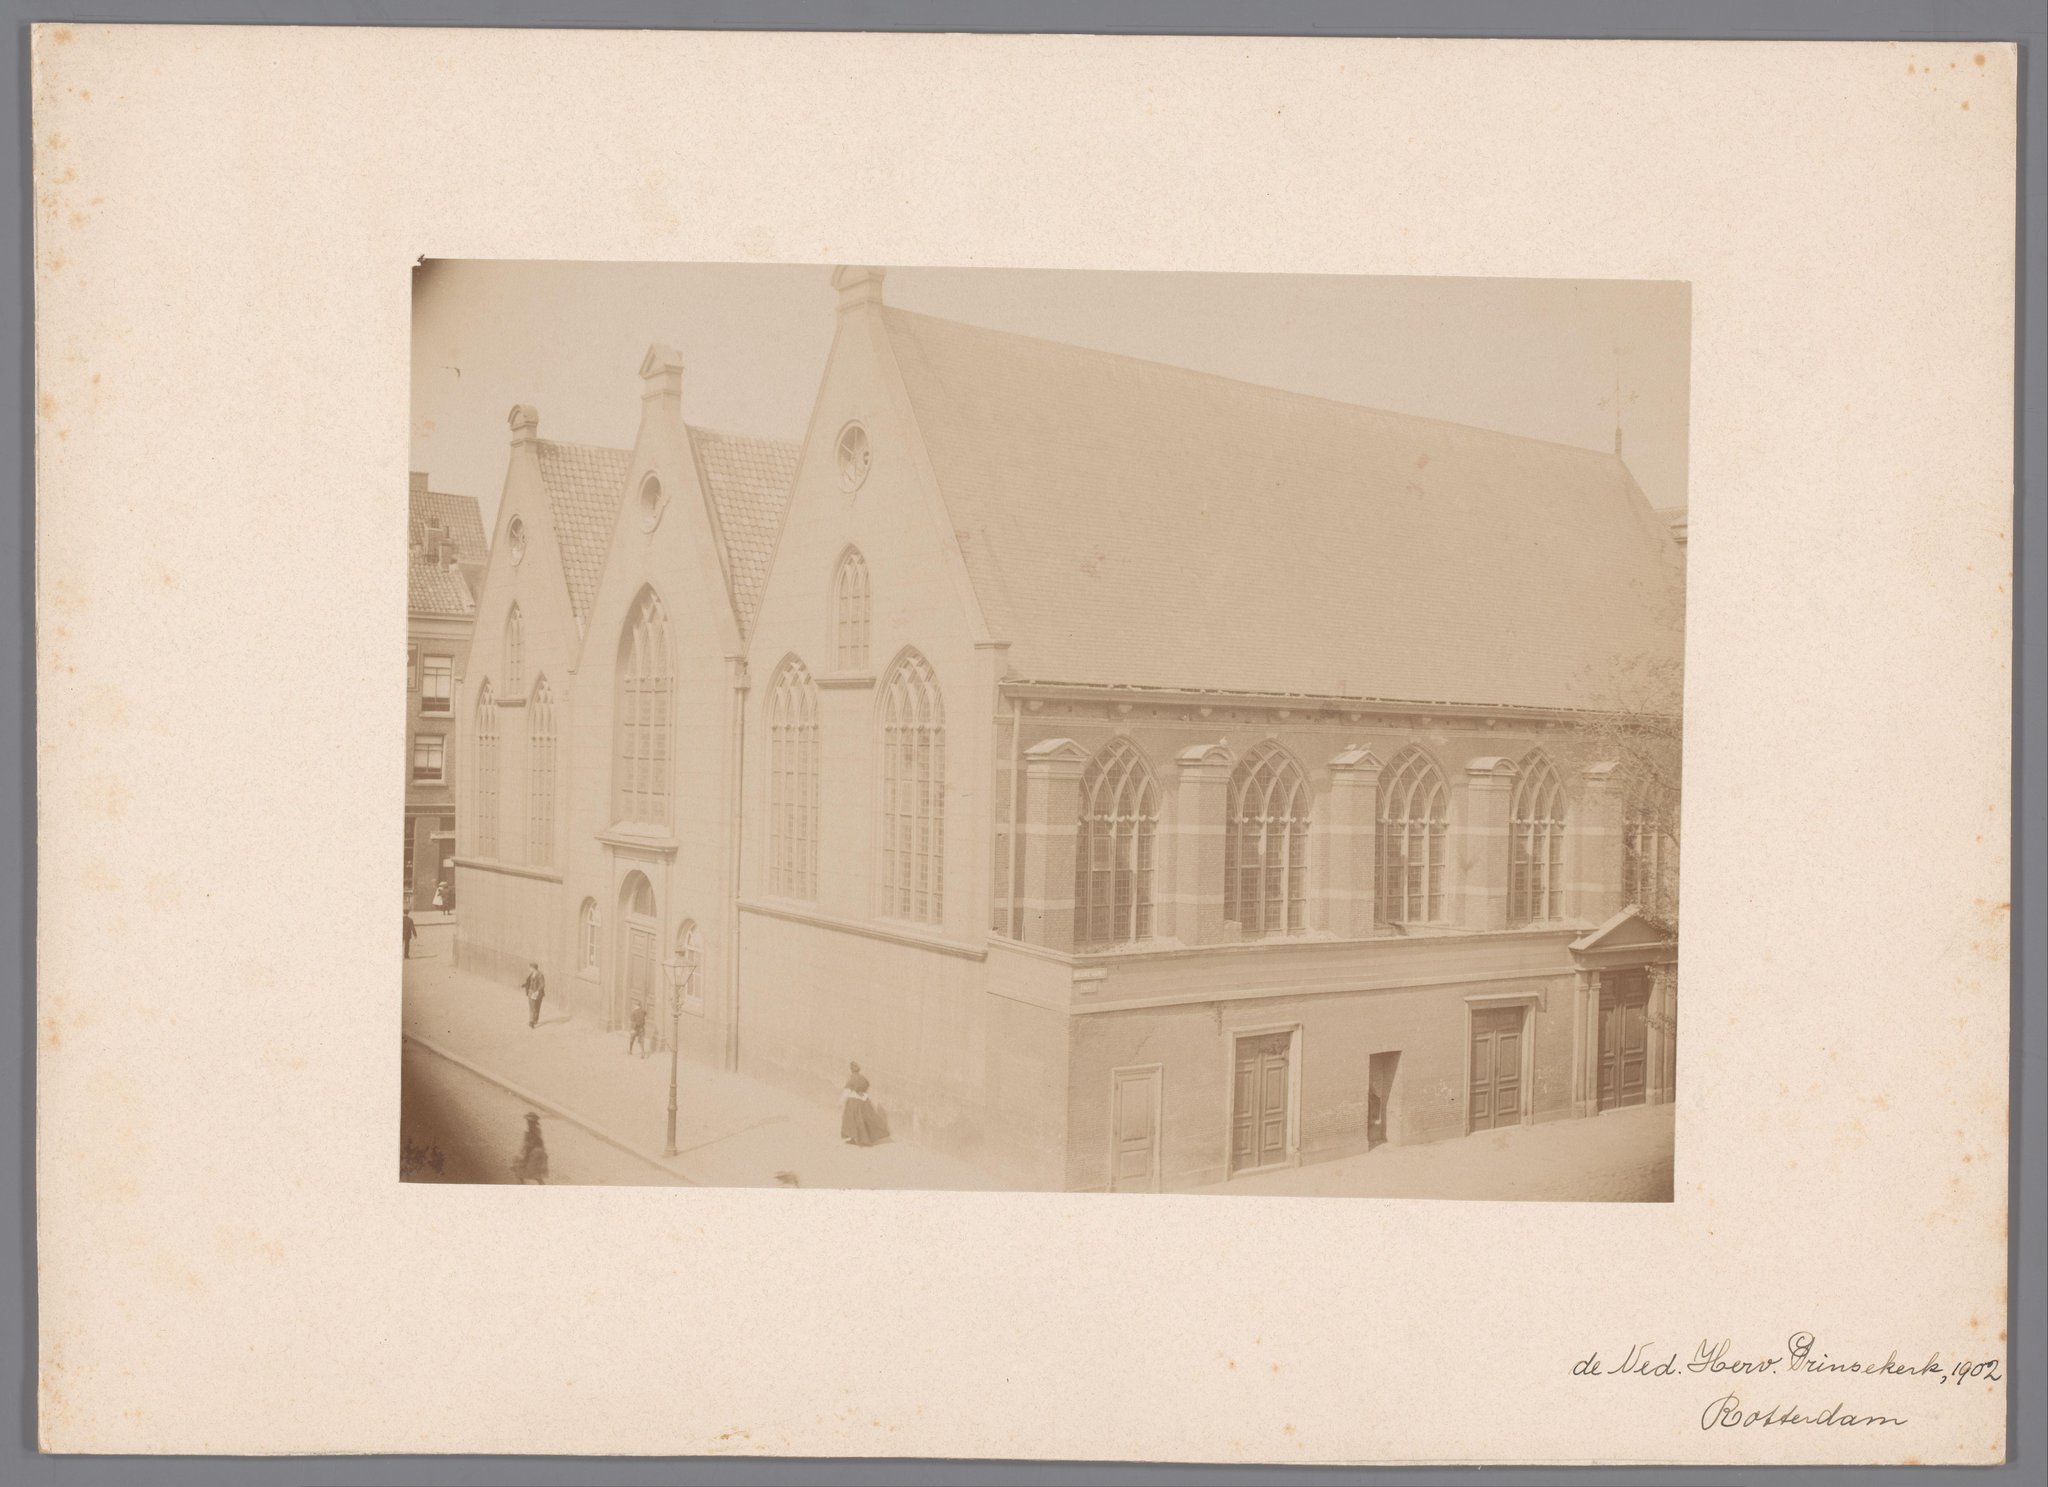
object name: photograph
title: Gezicht op de Nederlands-hervormde Prinsekerk te Rotterdam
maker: anoniem (monumentenzorg)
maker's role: fotograaf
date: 1902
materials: cardboard, photographic support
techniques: albumen print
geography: botersloot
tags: church (exterior)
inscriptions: collector's mark: ‘R.MUS.’, annotation: ‘Rotterdam (Z.H.)/ Prinsenkerk/ Mei 1902’, annotation: ‘de Ned. Herv. Prinsekerk, 1902/ Rotterdam’